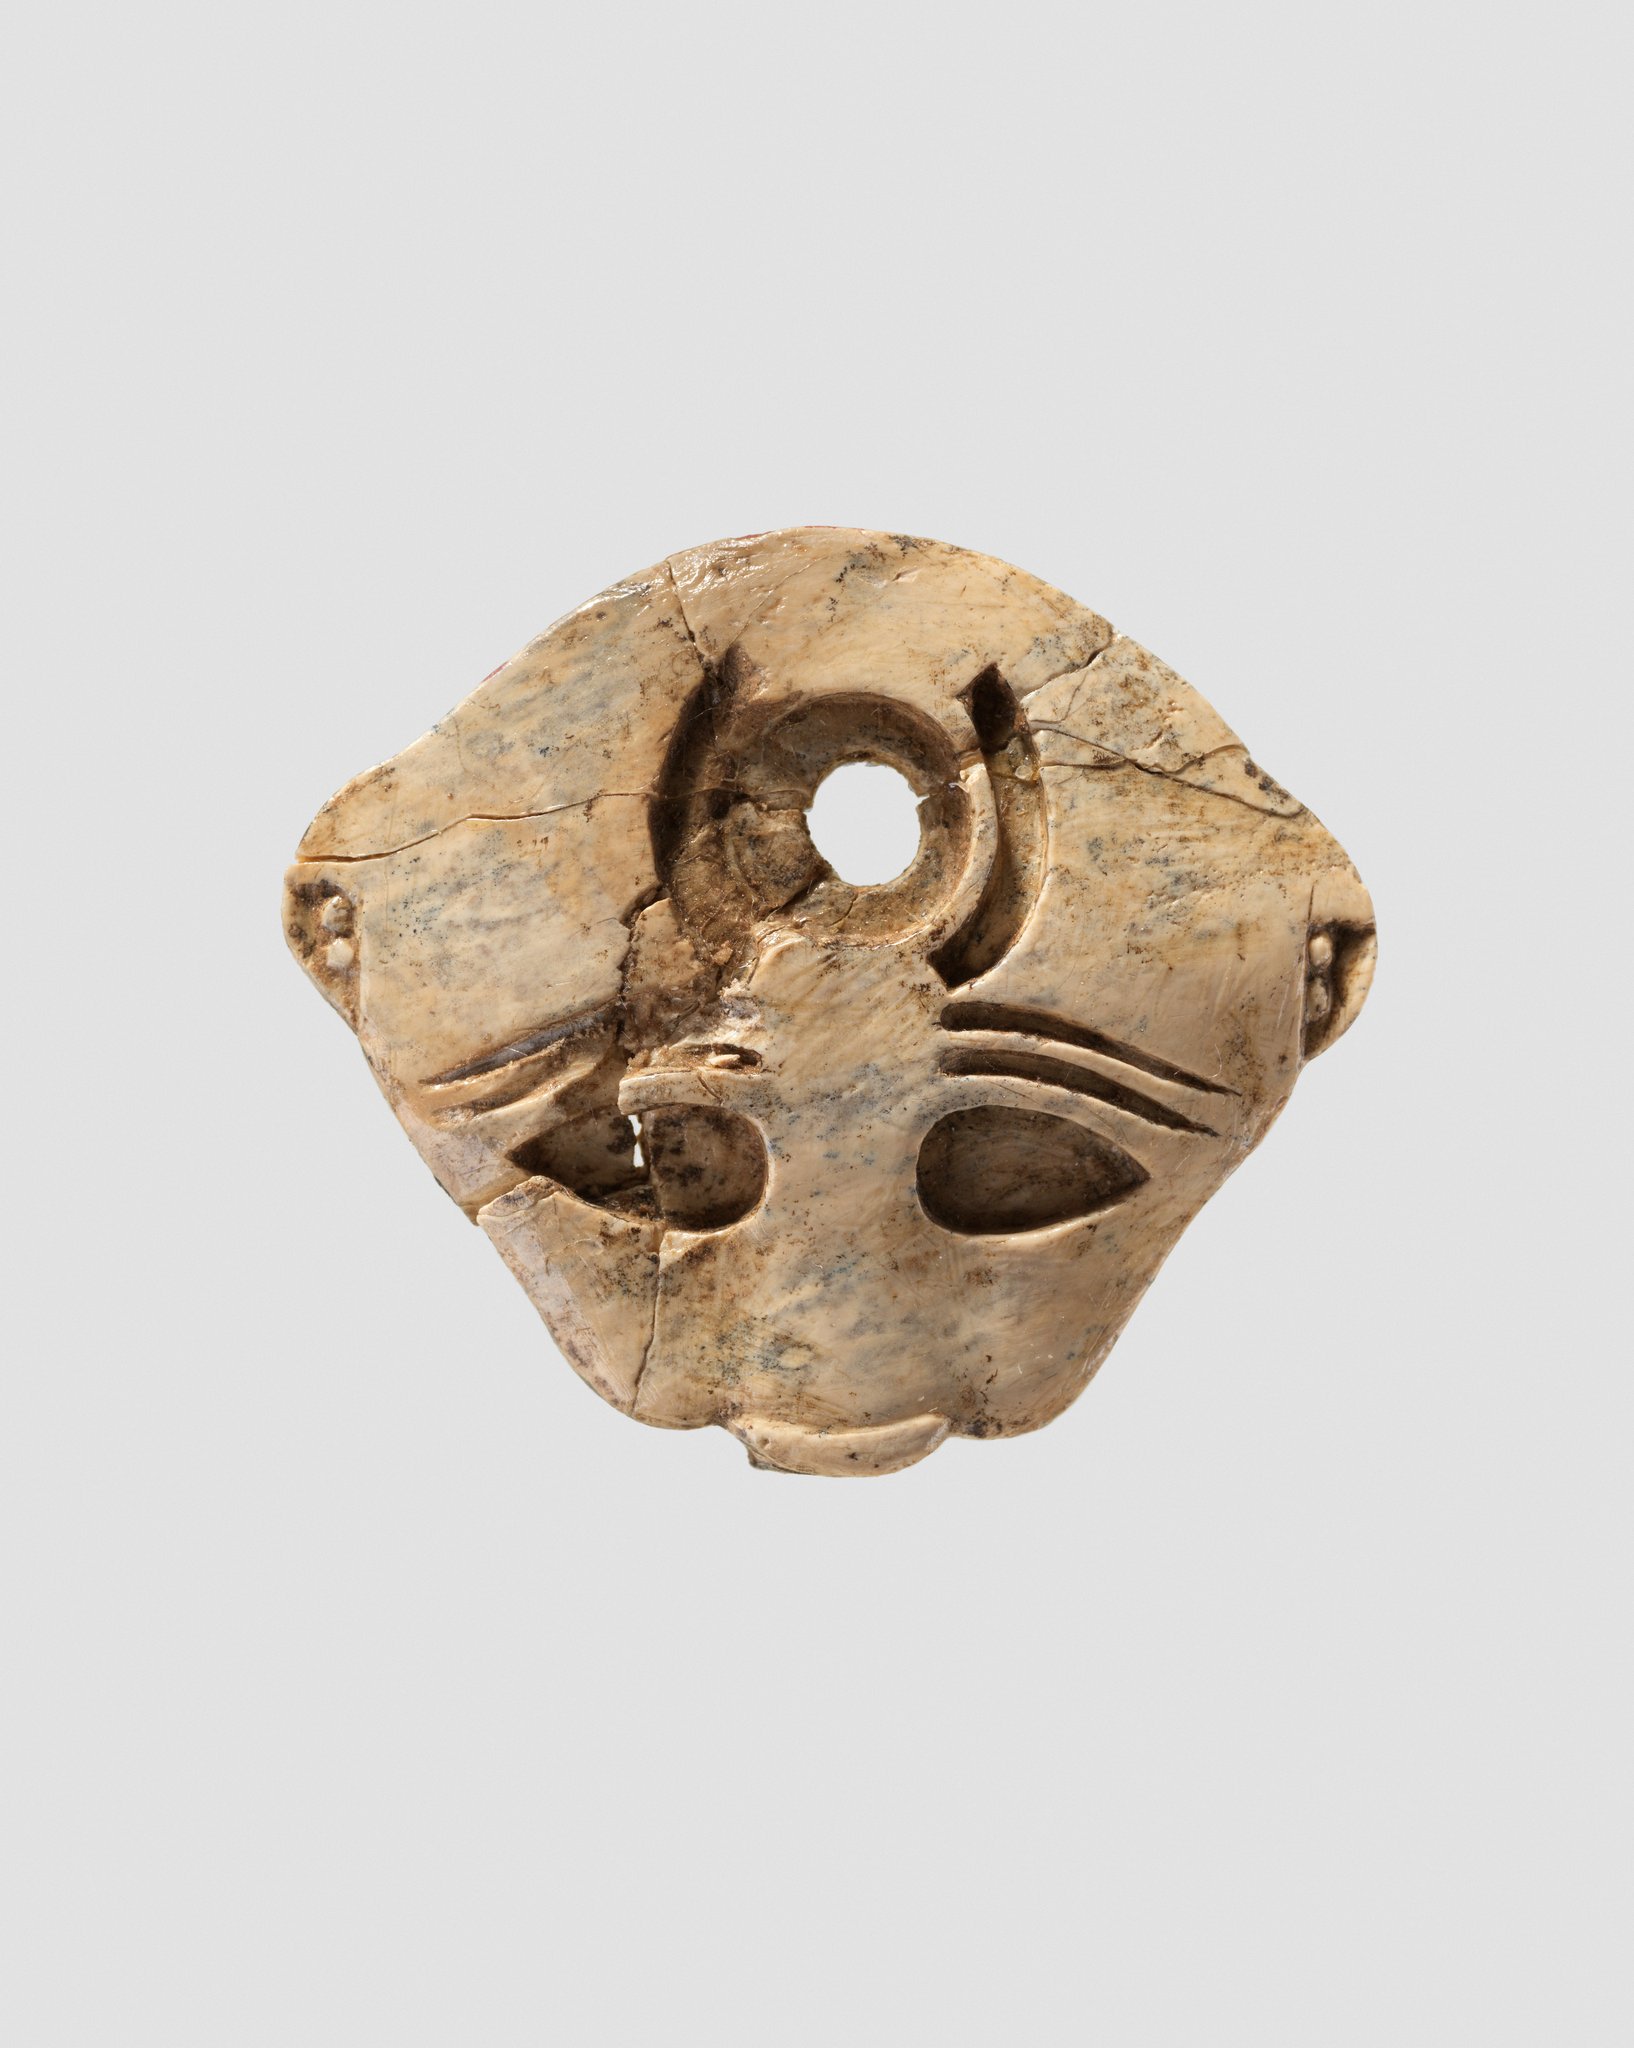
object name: sculpture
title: Lioness head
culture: assyrian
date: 800-601 BCE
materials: ivory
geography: mesopotamia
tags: lions